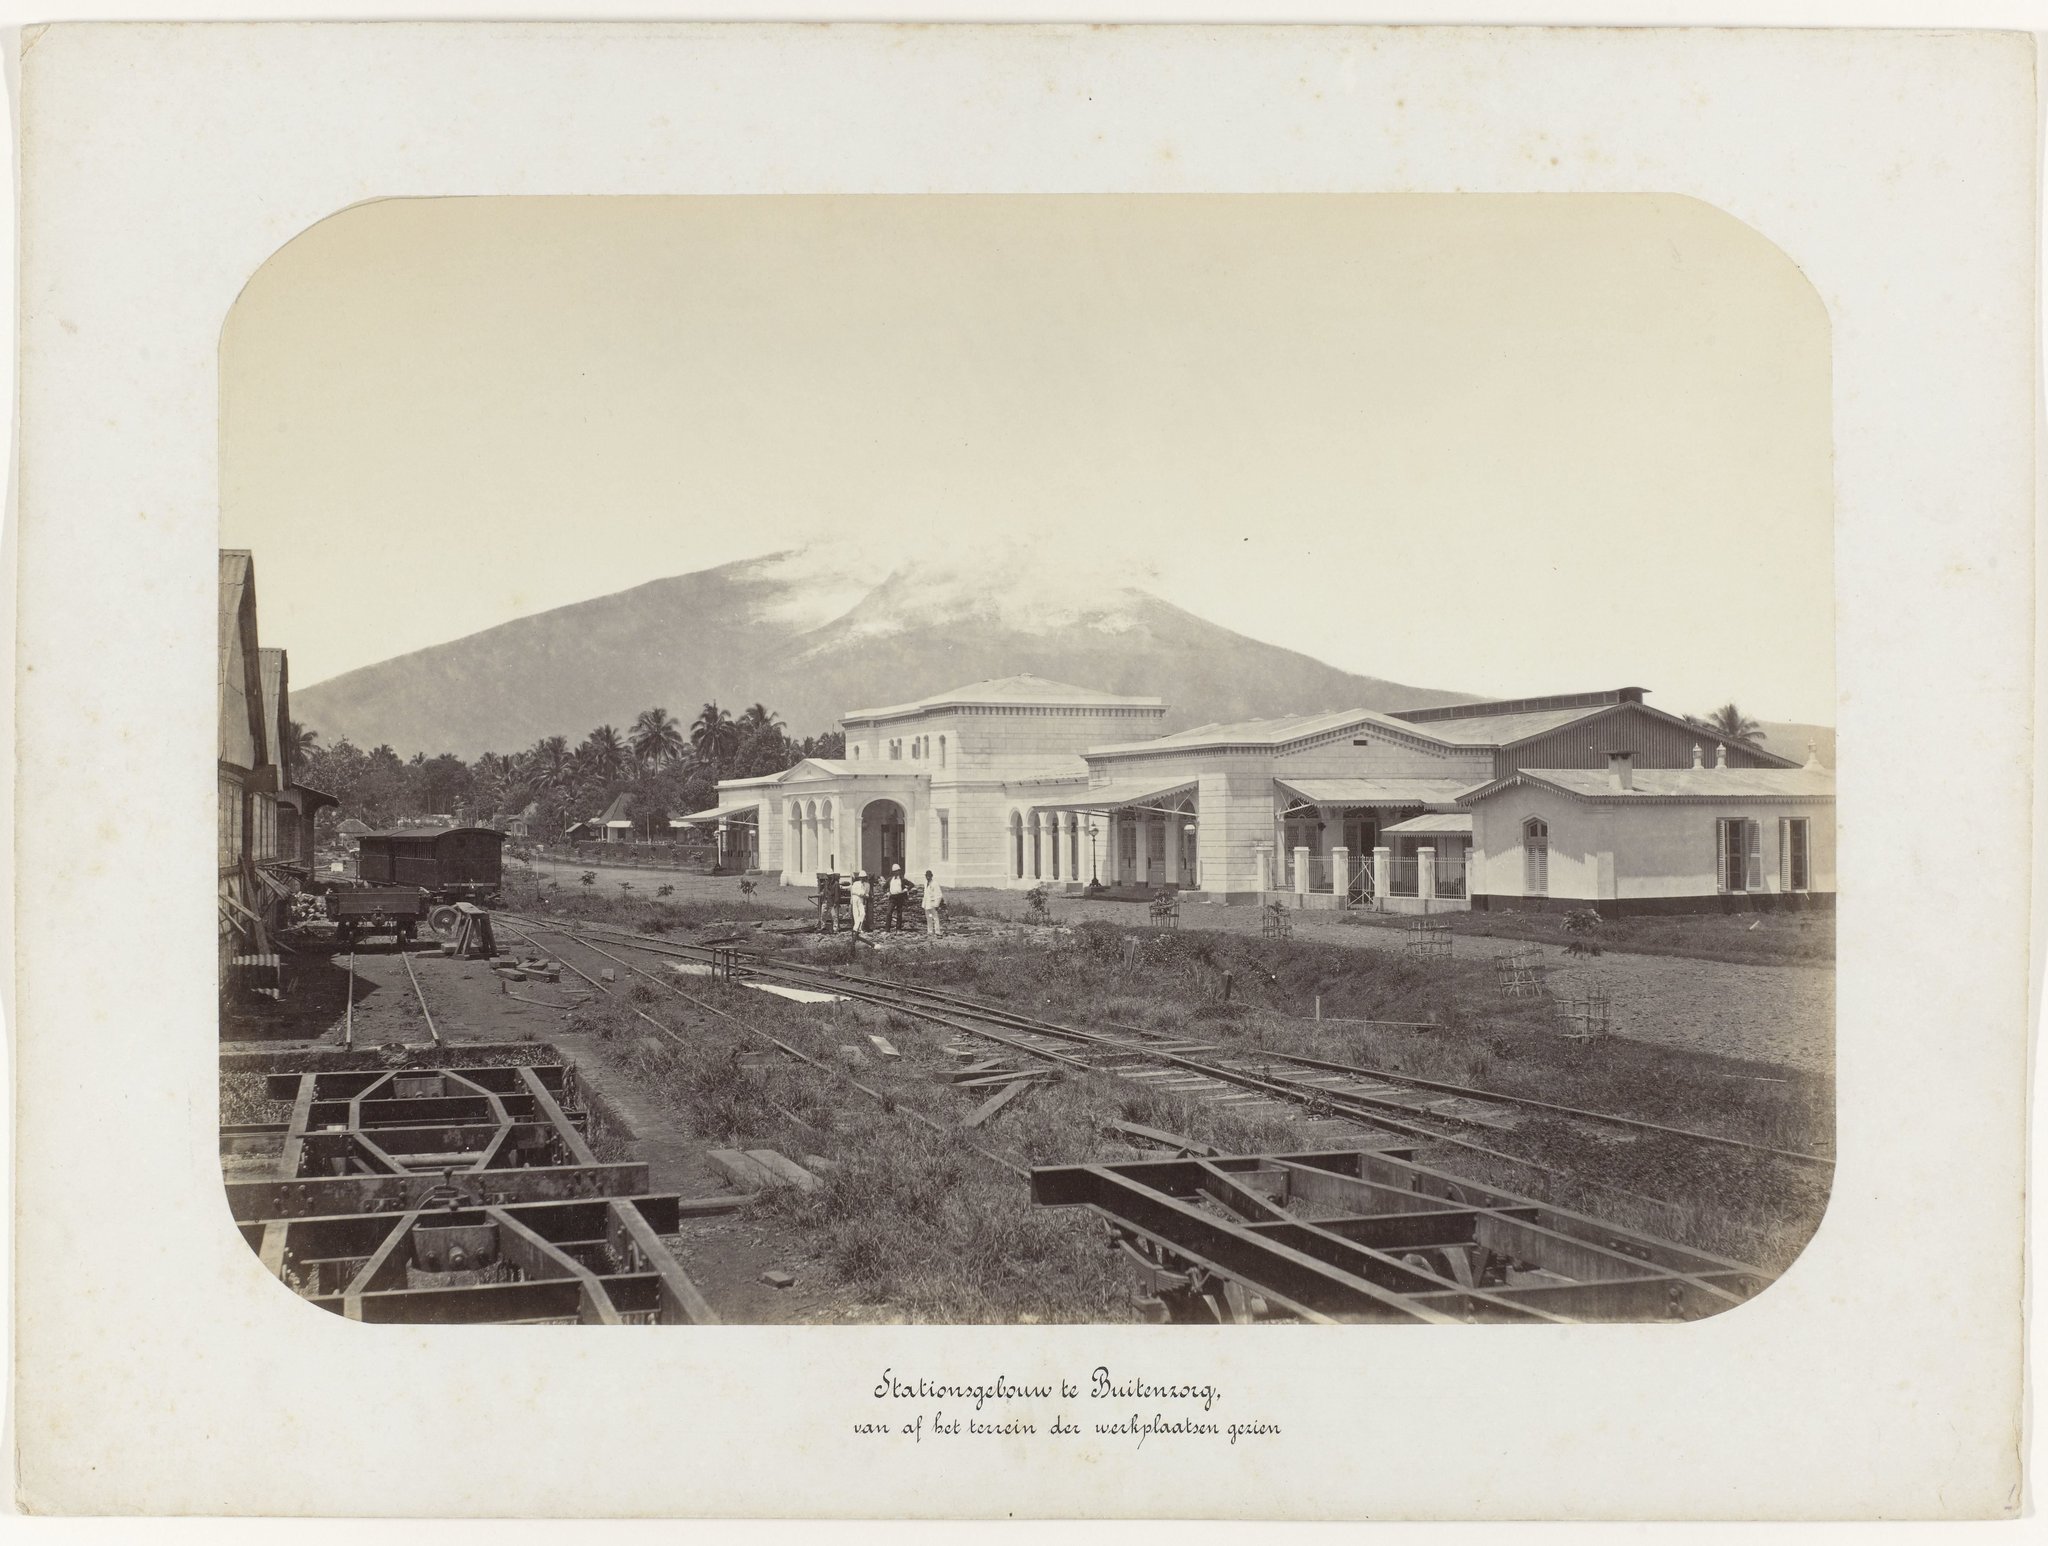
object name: photograph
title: Stationsgebouw te Buitenzorg, vanaf het terrein der werkplaatsen gezien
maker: Anonymous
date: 1880-1888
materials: photographic support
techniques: albumen print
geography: java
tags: buitenzorg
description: Het stationsgebouw te Buitenzorg, vanaf het terrein der werkplaatsen gezien. Onderdeel van een groep van 62 foto's in een doos met het opschrift "Staatsspoorwegen op Java" uit 1888.